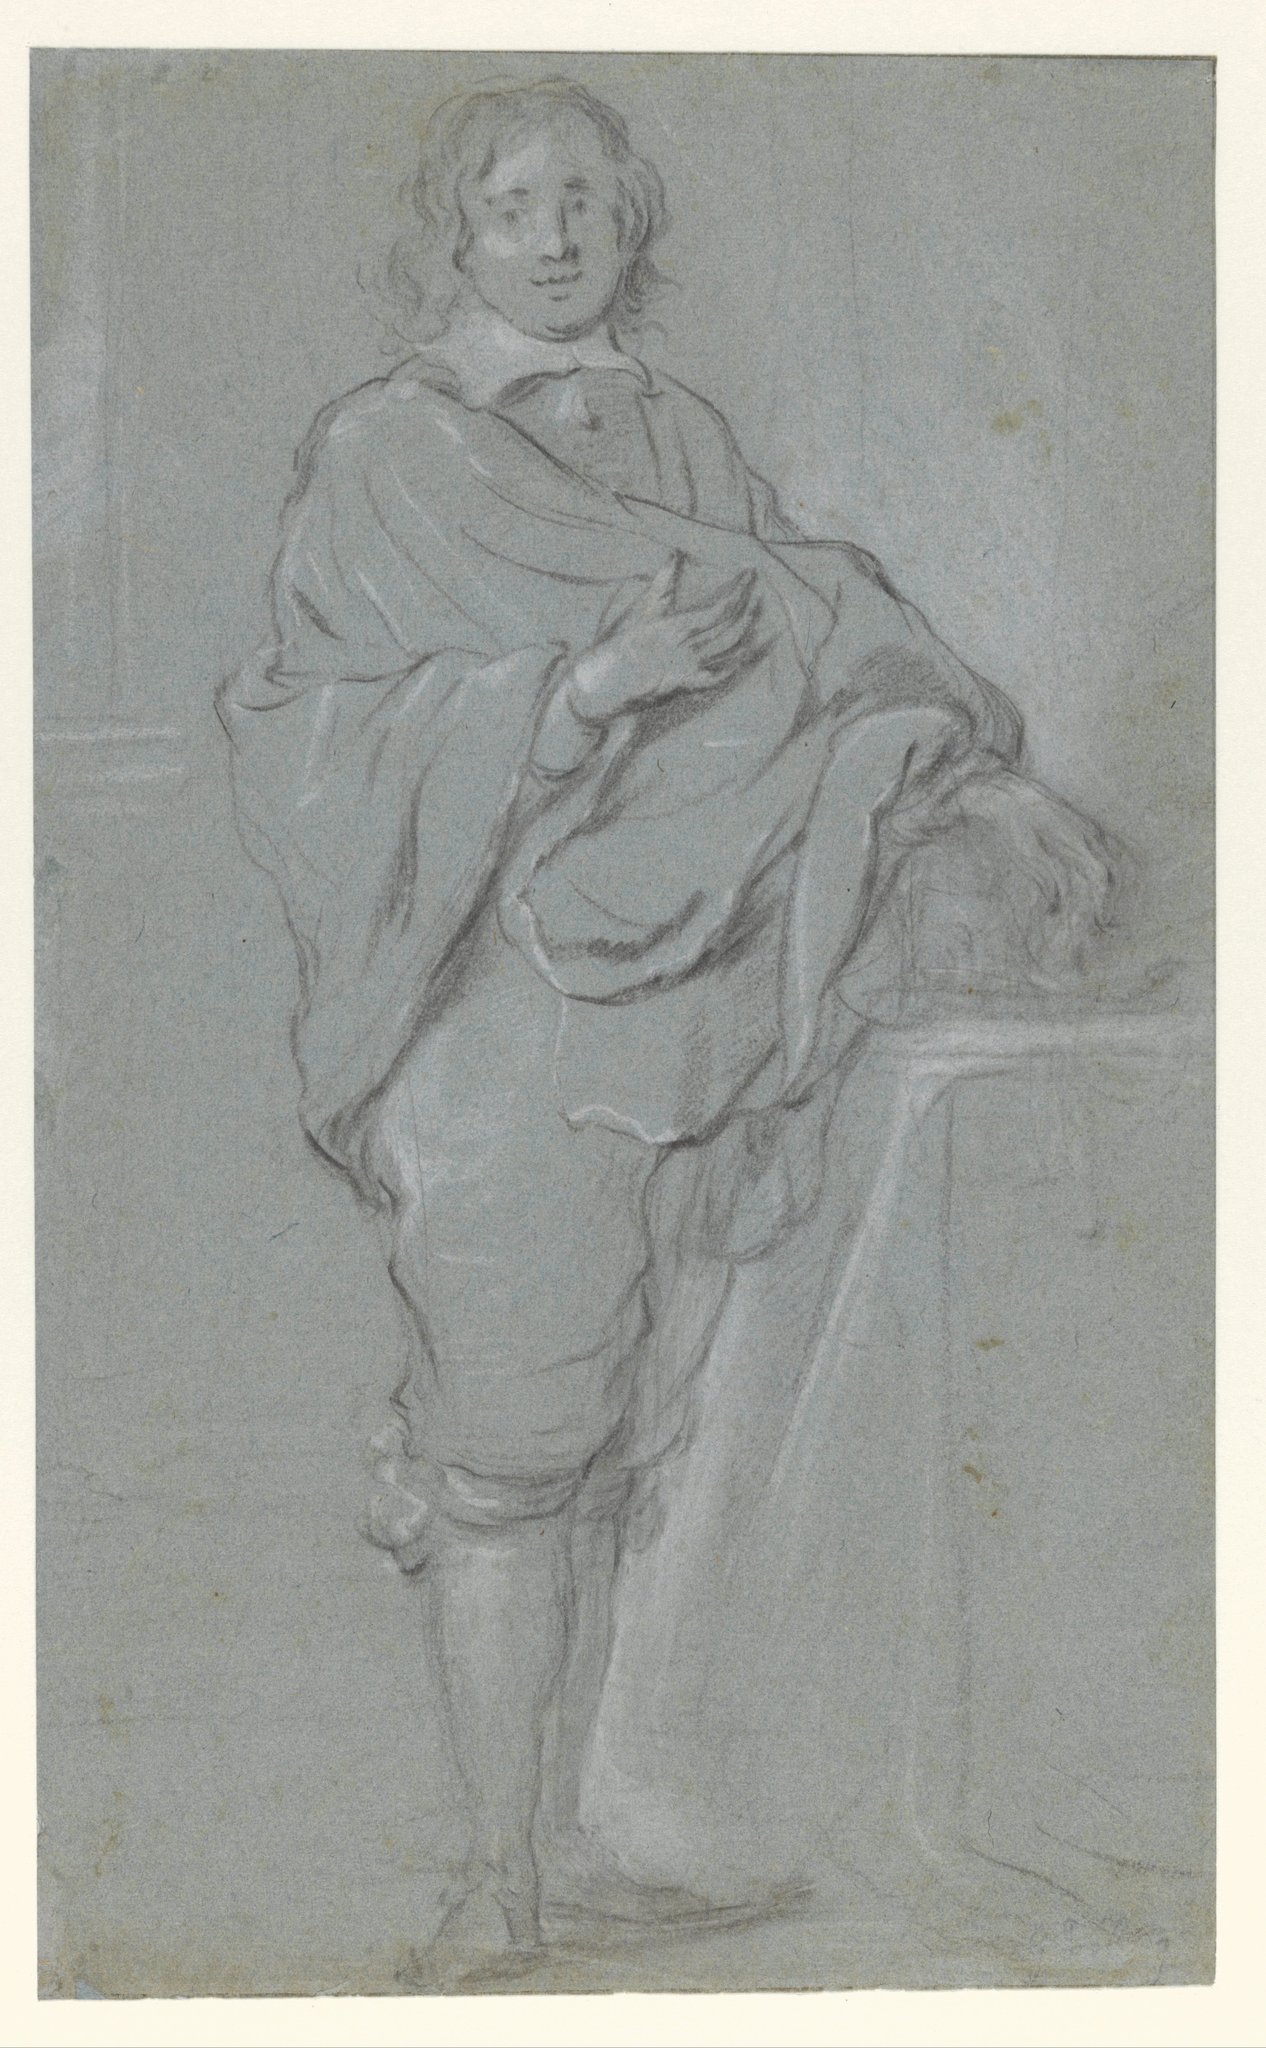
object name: drawing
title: Staande man bij een tafel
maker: govert flinck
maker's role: draughtsman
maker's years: 1615-1660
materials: chalk, paper